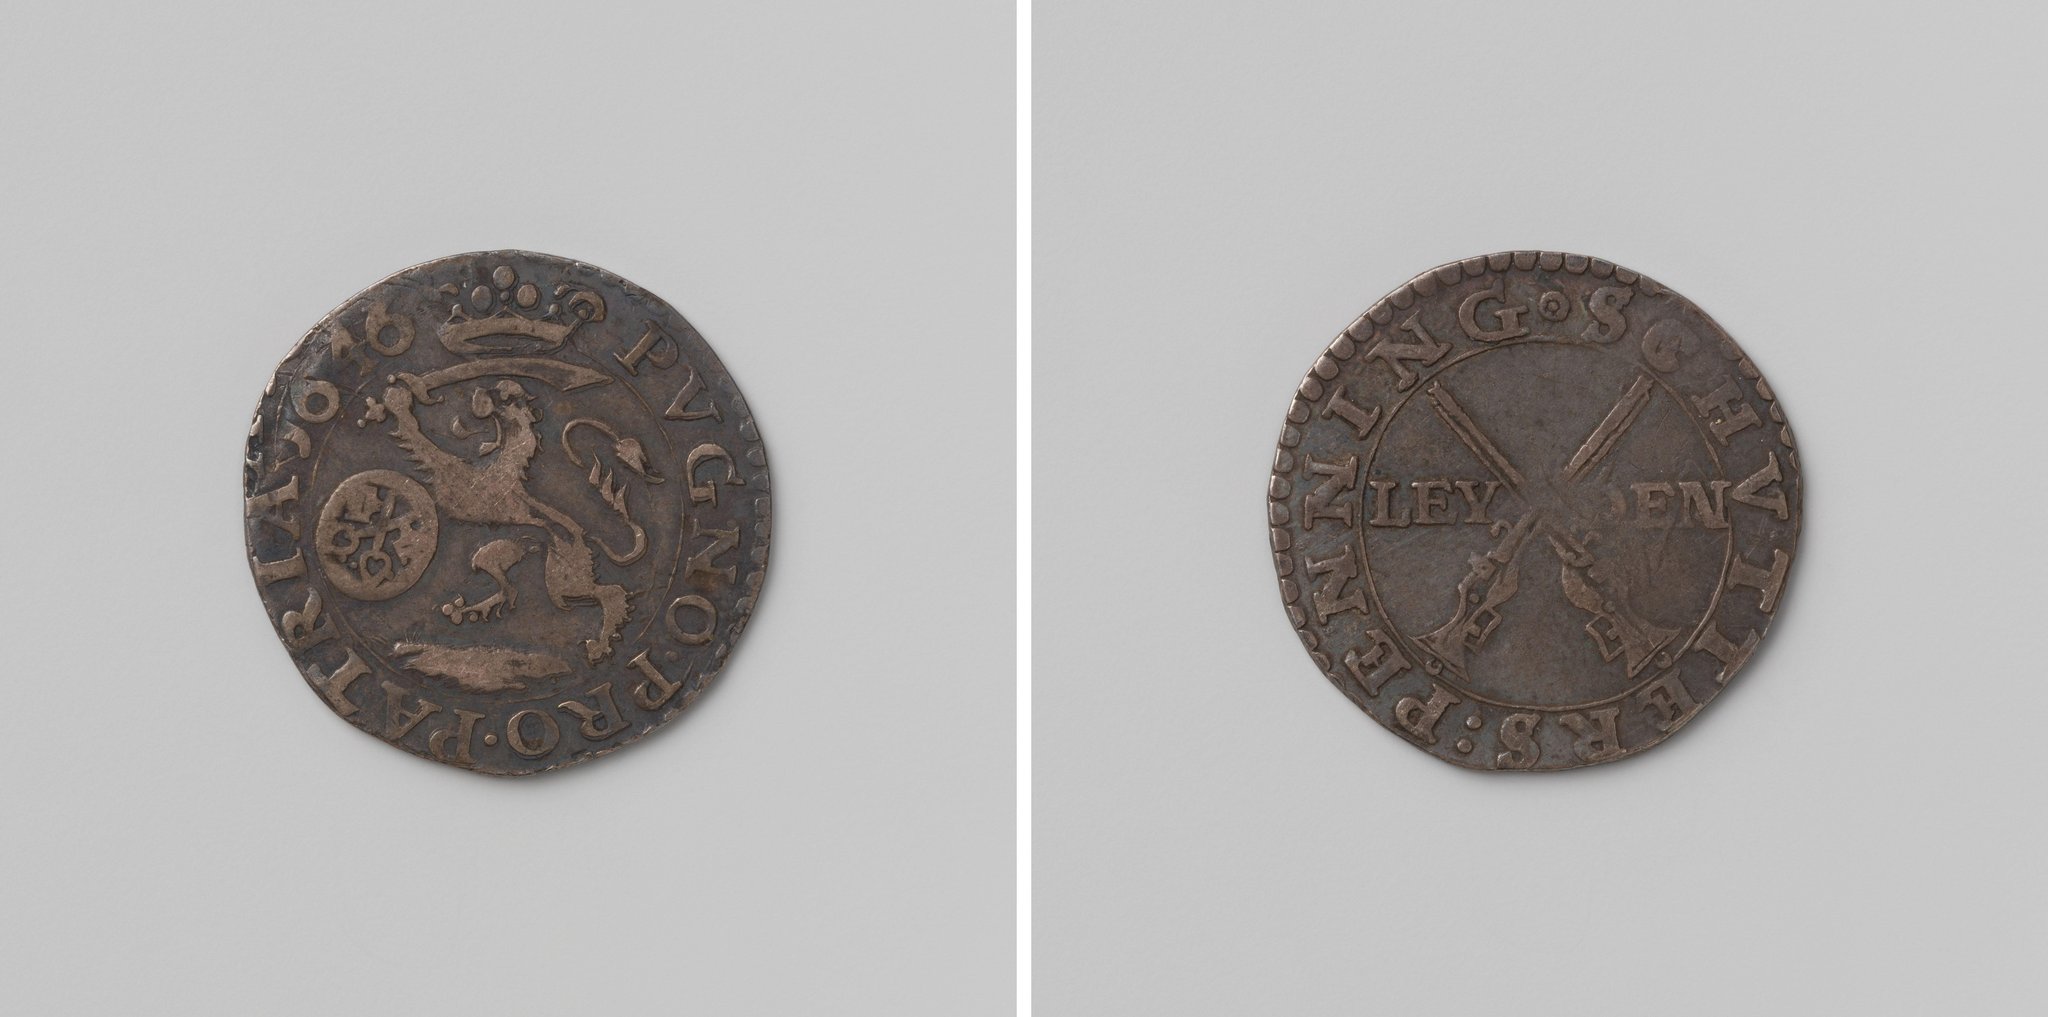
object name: marksman medal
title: Schutterij van Leiden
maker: george pullein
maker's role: medailleur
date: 1646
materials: silver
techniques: striking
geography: leiden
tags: leiden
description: Zilveren penning. Voorzijde: leeuw met zwaard in boven hoofd geheven rechterklauw en schild in linkerklauw onder kroon binnen omschrift. Keerzijde: twee gekruiste musketten tussen opschrift binnen omschrift